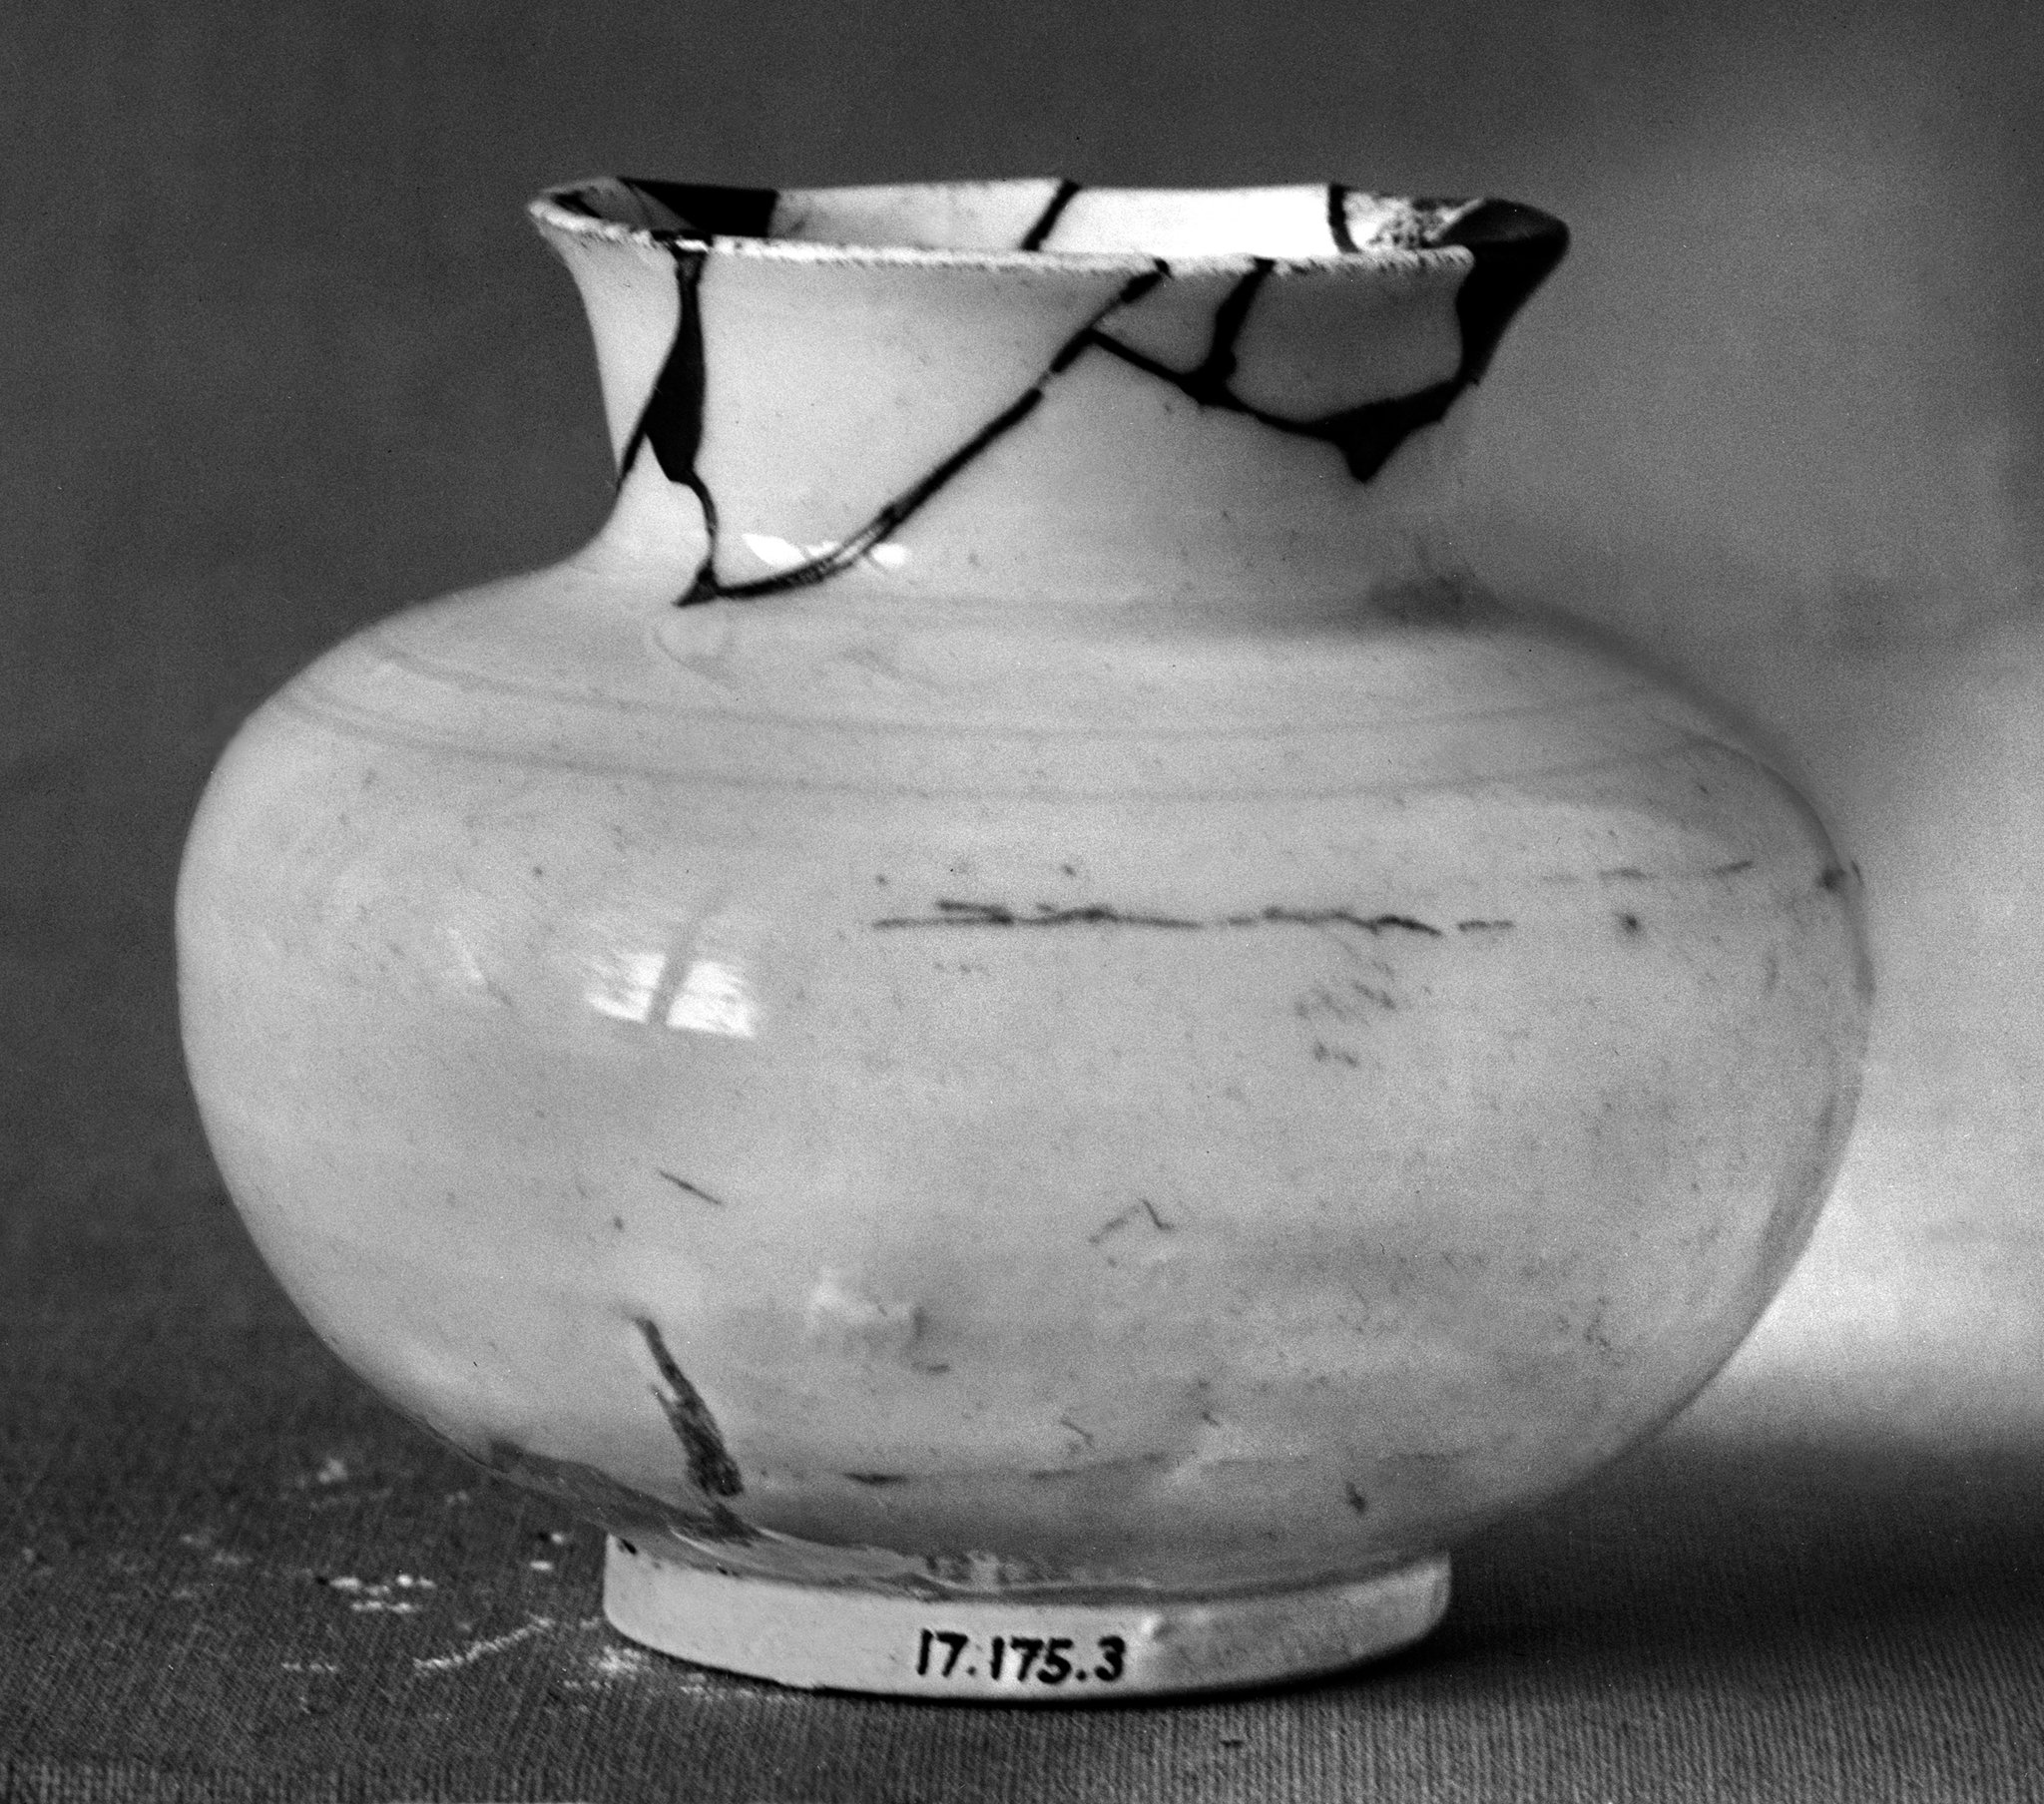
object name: pot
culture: korean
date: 918-1392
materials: clay